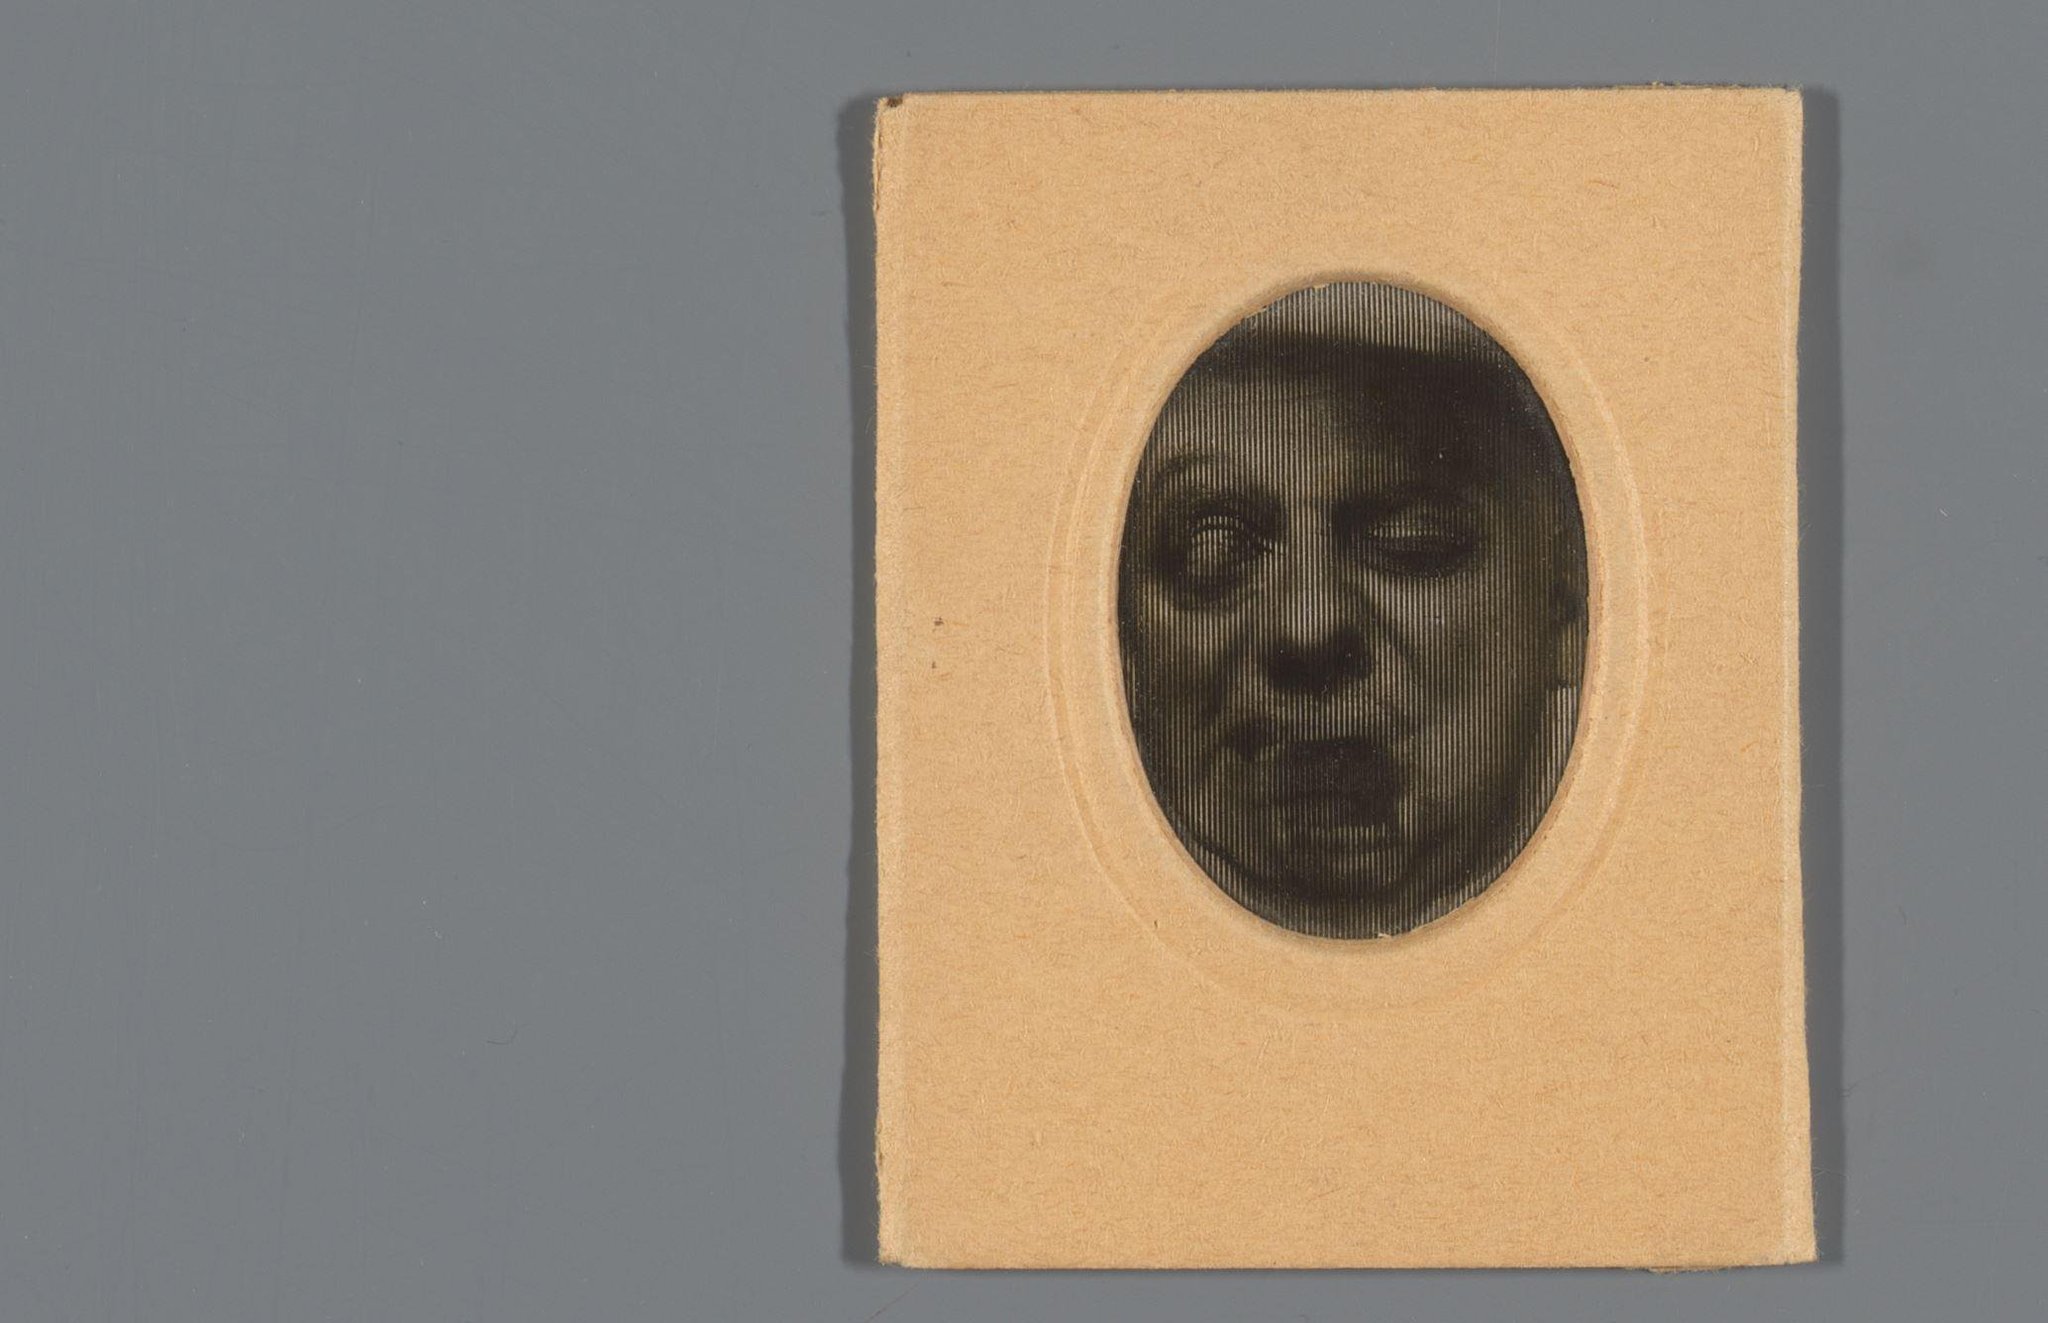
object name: photograph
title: Man met gesloten en opengesperde mond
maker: Anonymous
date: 1930-1950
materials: paper, cardboard, plastic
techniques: gelatin silver print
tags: mouth slightly open, adult man